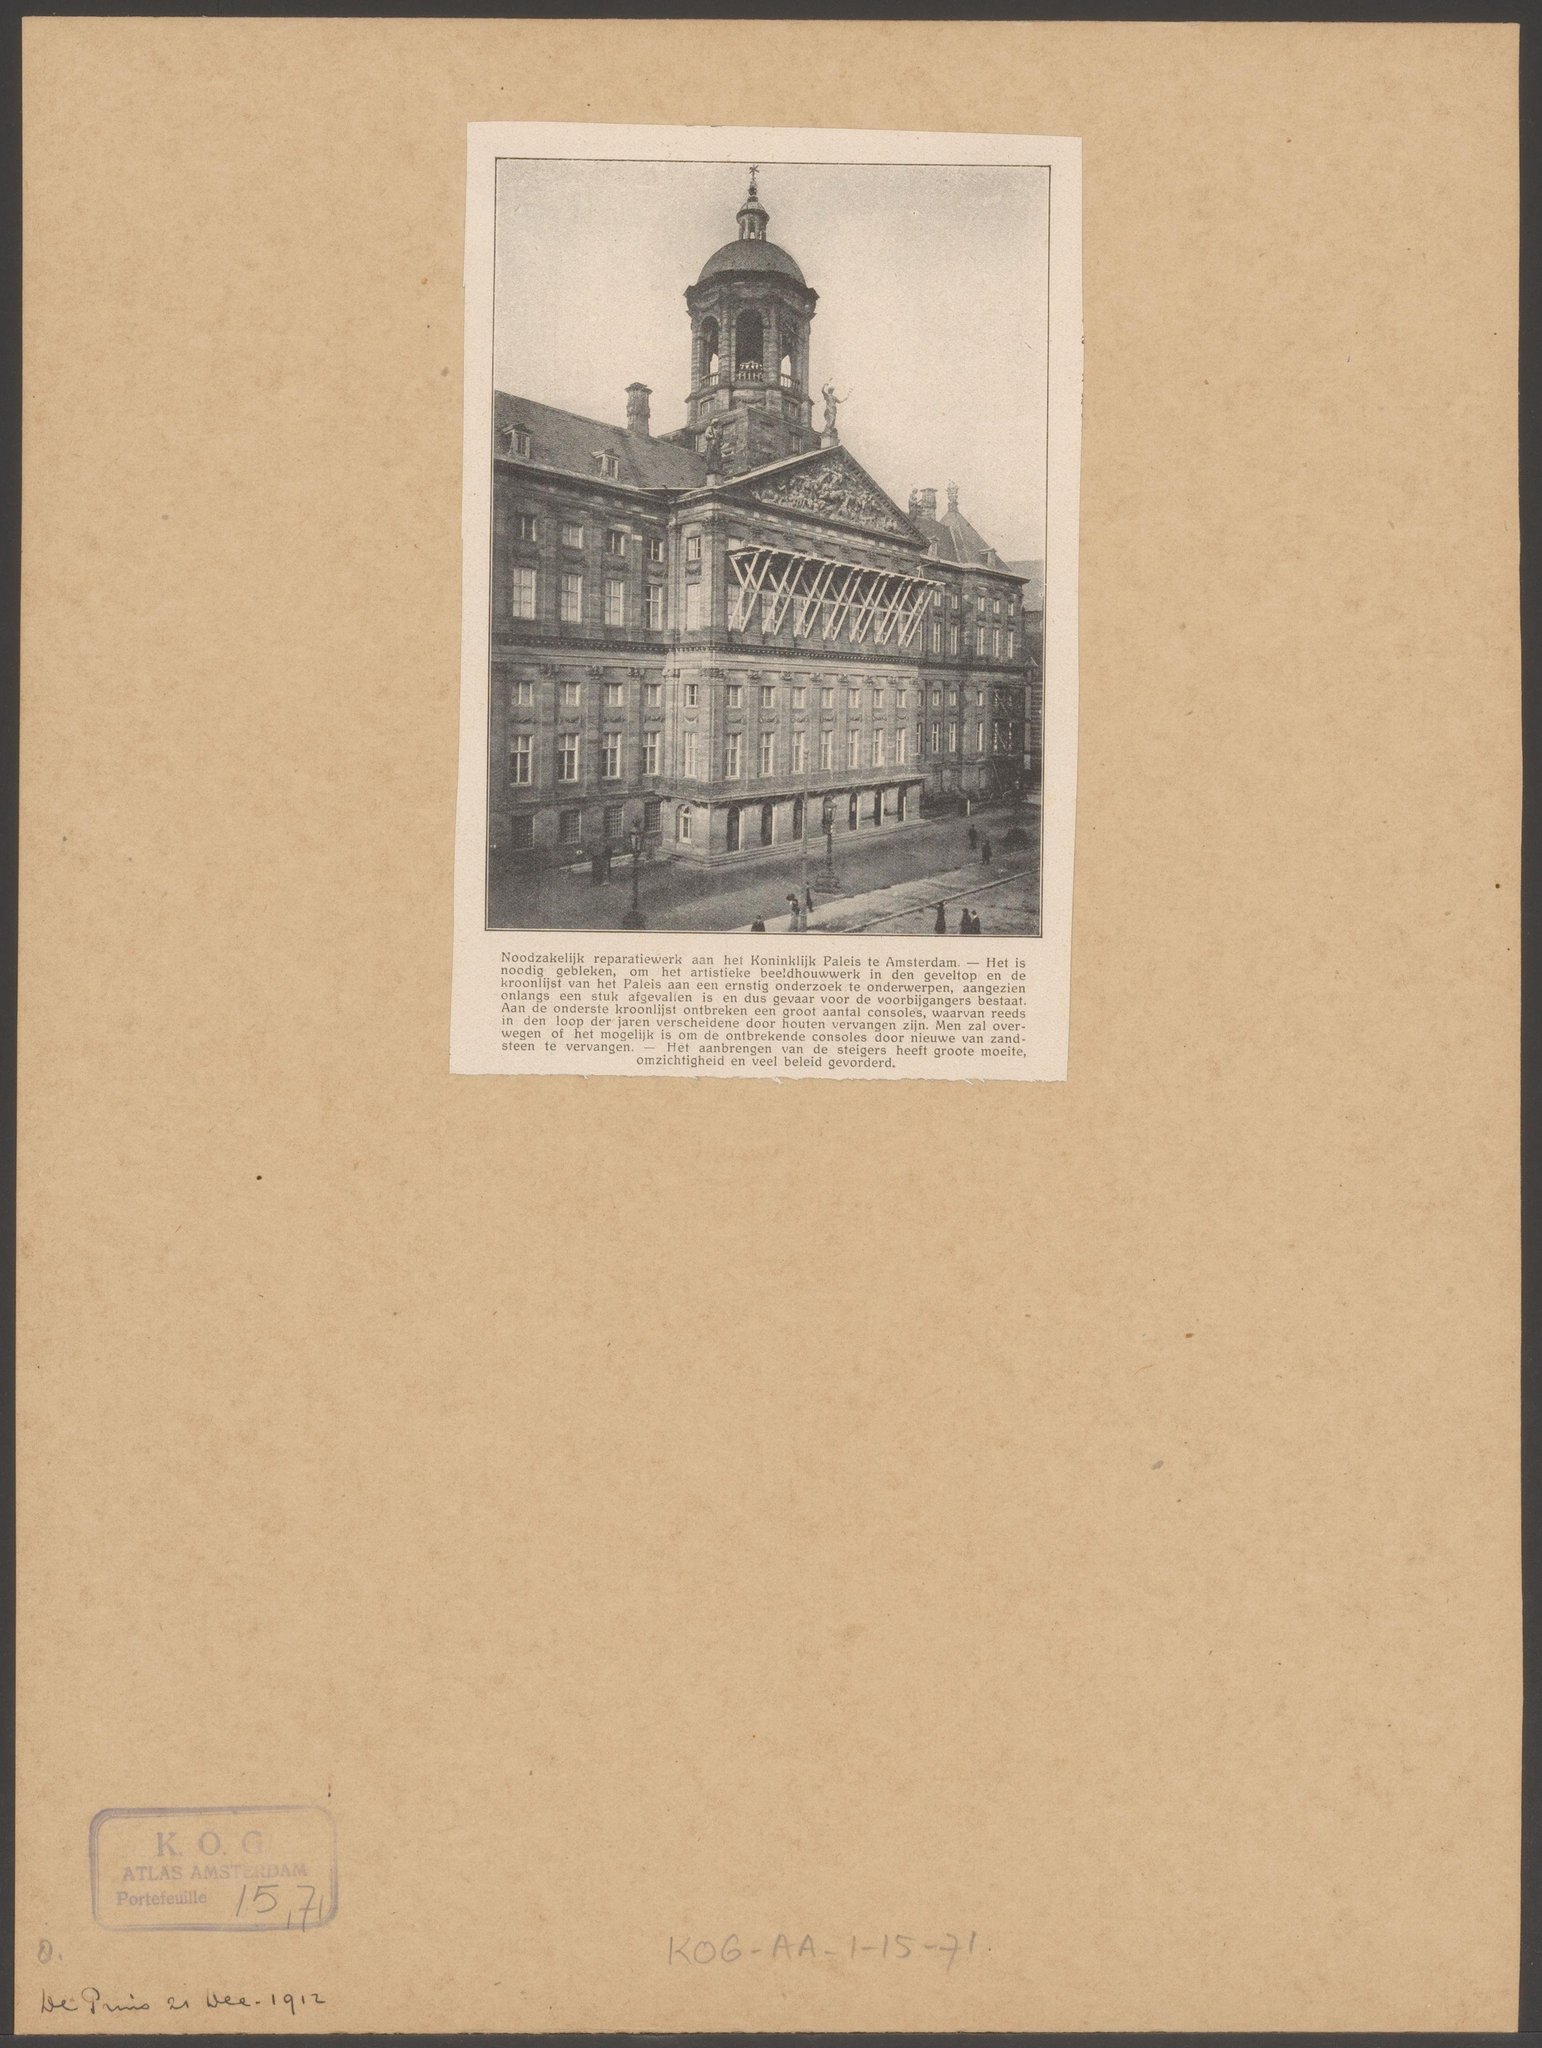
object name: photomechanical print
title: Gezicht op het Paleis op de Dam met een deel van de gevel in de steigers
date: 1912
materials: paper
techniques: letterpress printing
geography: amsterdam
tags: scaffold (~ building activities), city-view in general; 'veduta', palace, façade (of house or building), royal palace of amsterdam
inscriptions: collector's mark: ‘15,71’ Lugt 1641b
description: Onderwerpsrubriek binnen de Atlas Amsterdam: Nieuwe Stadhuis, als Paleis, op de Dam, van Buiten.